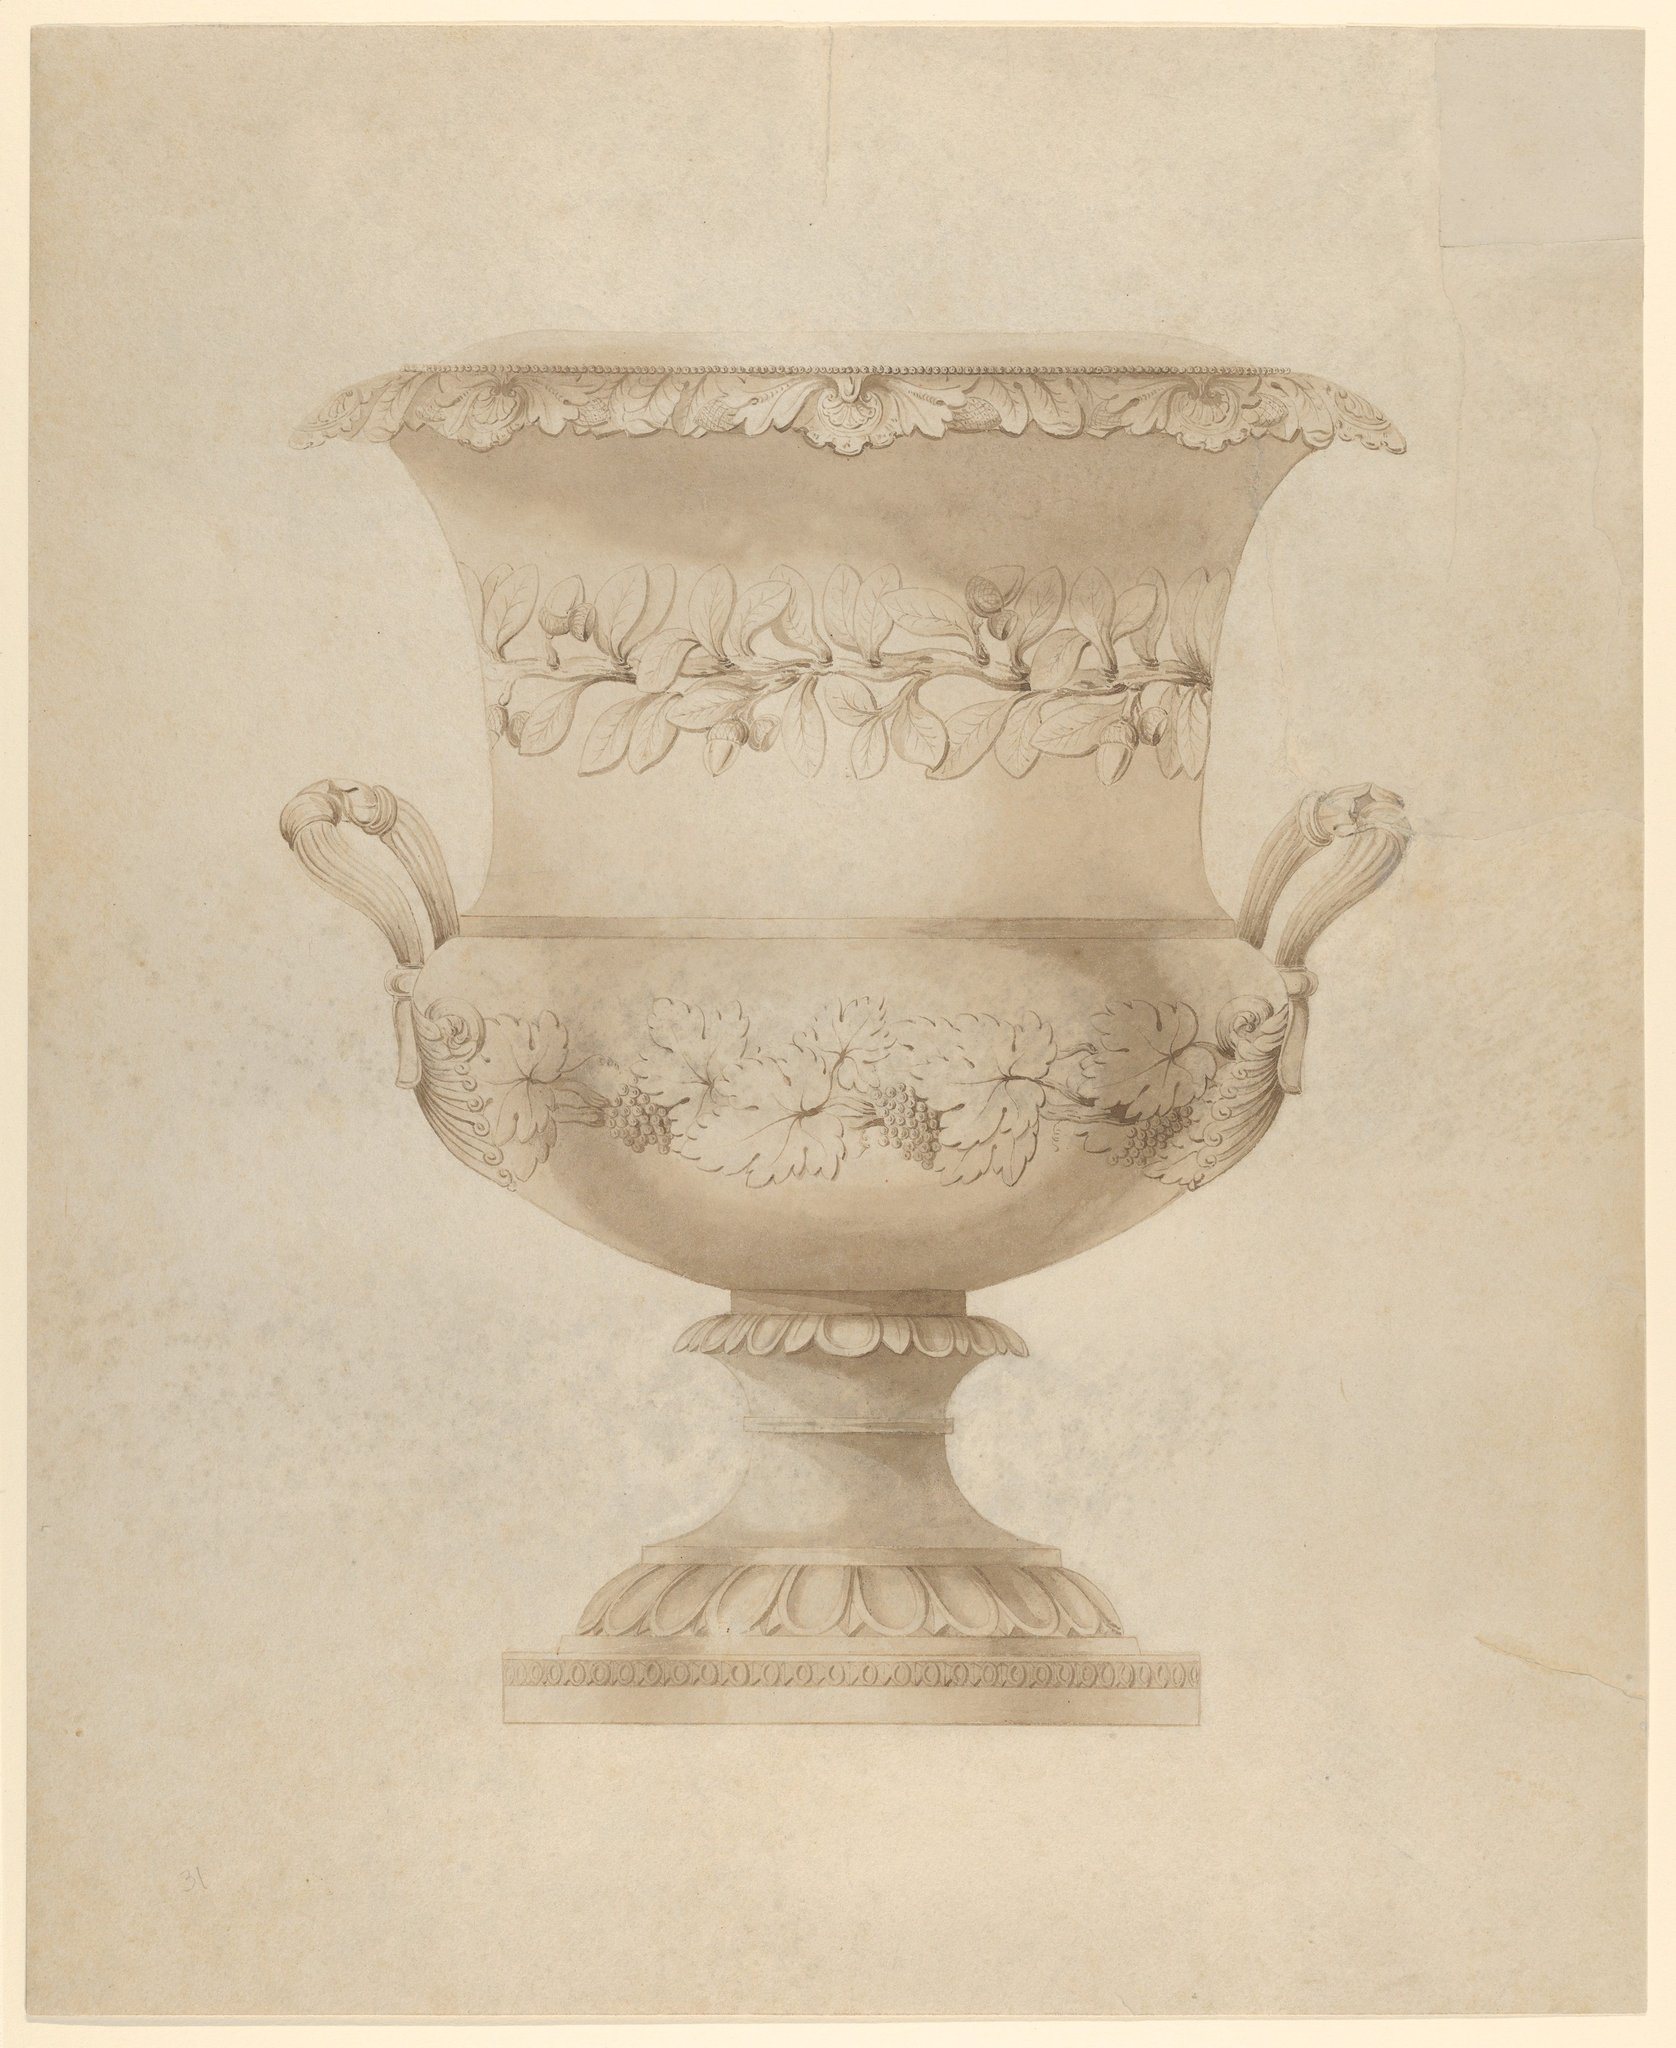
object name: drawing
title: Design for a wine cooler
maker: thomas fletcher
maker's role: artist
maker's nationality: american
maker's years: 1787-1866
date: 1825-1835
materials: ink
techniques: brush, pen, wash